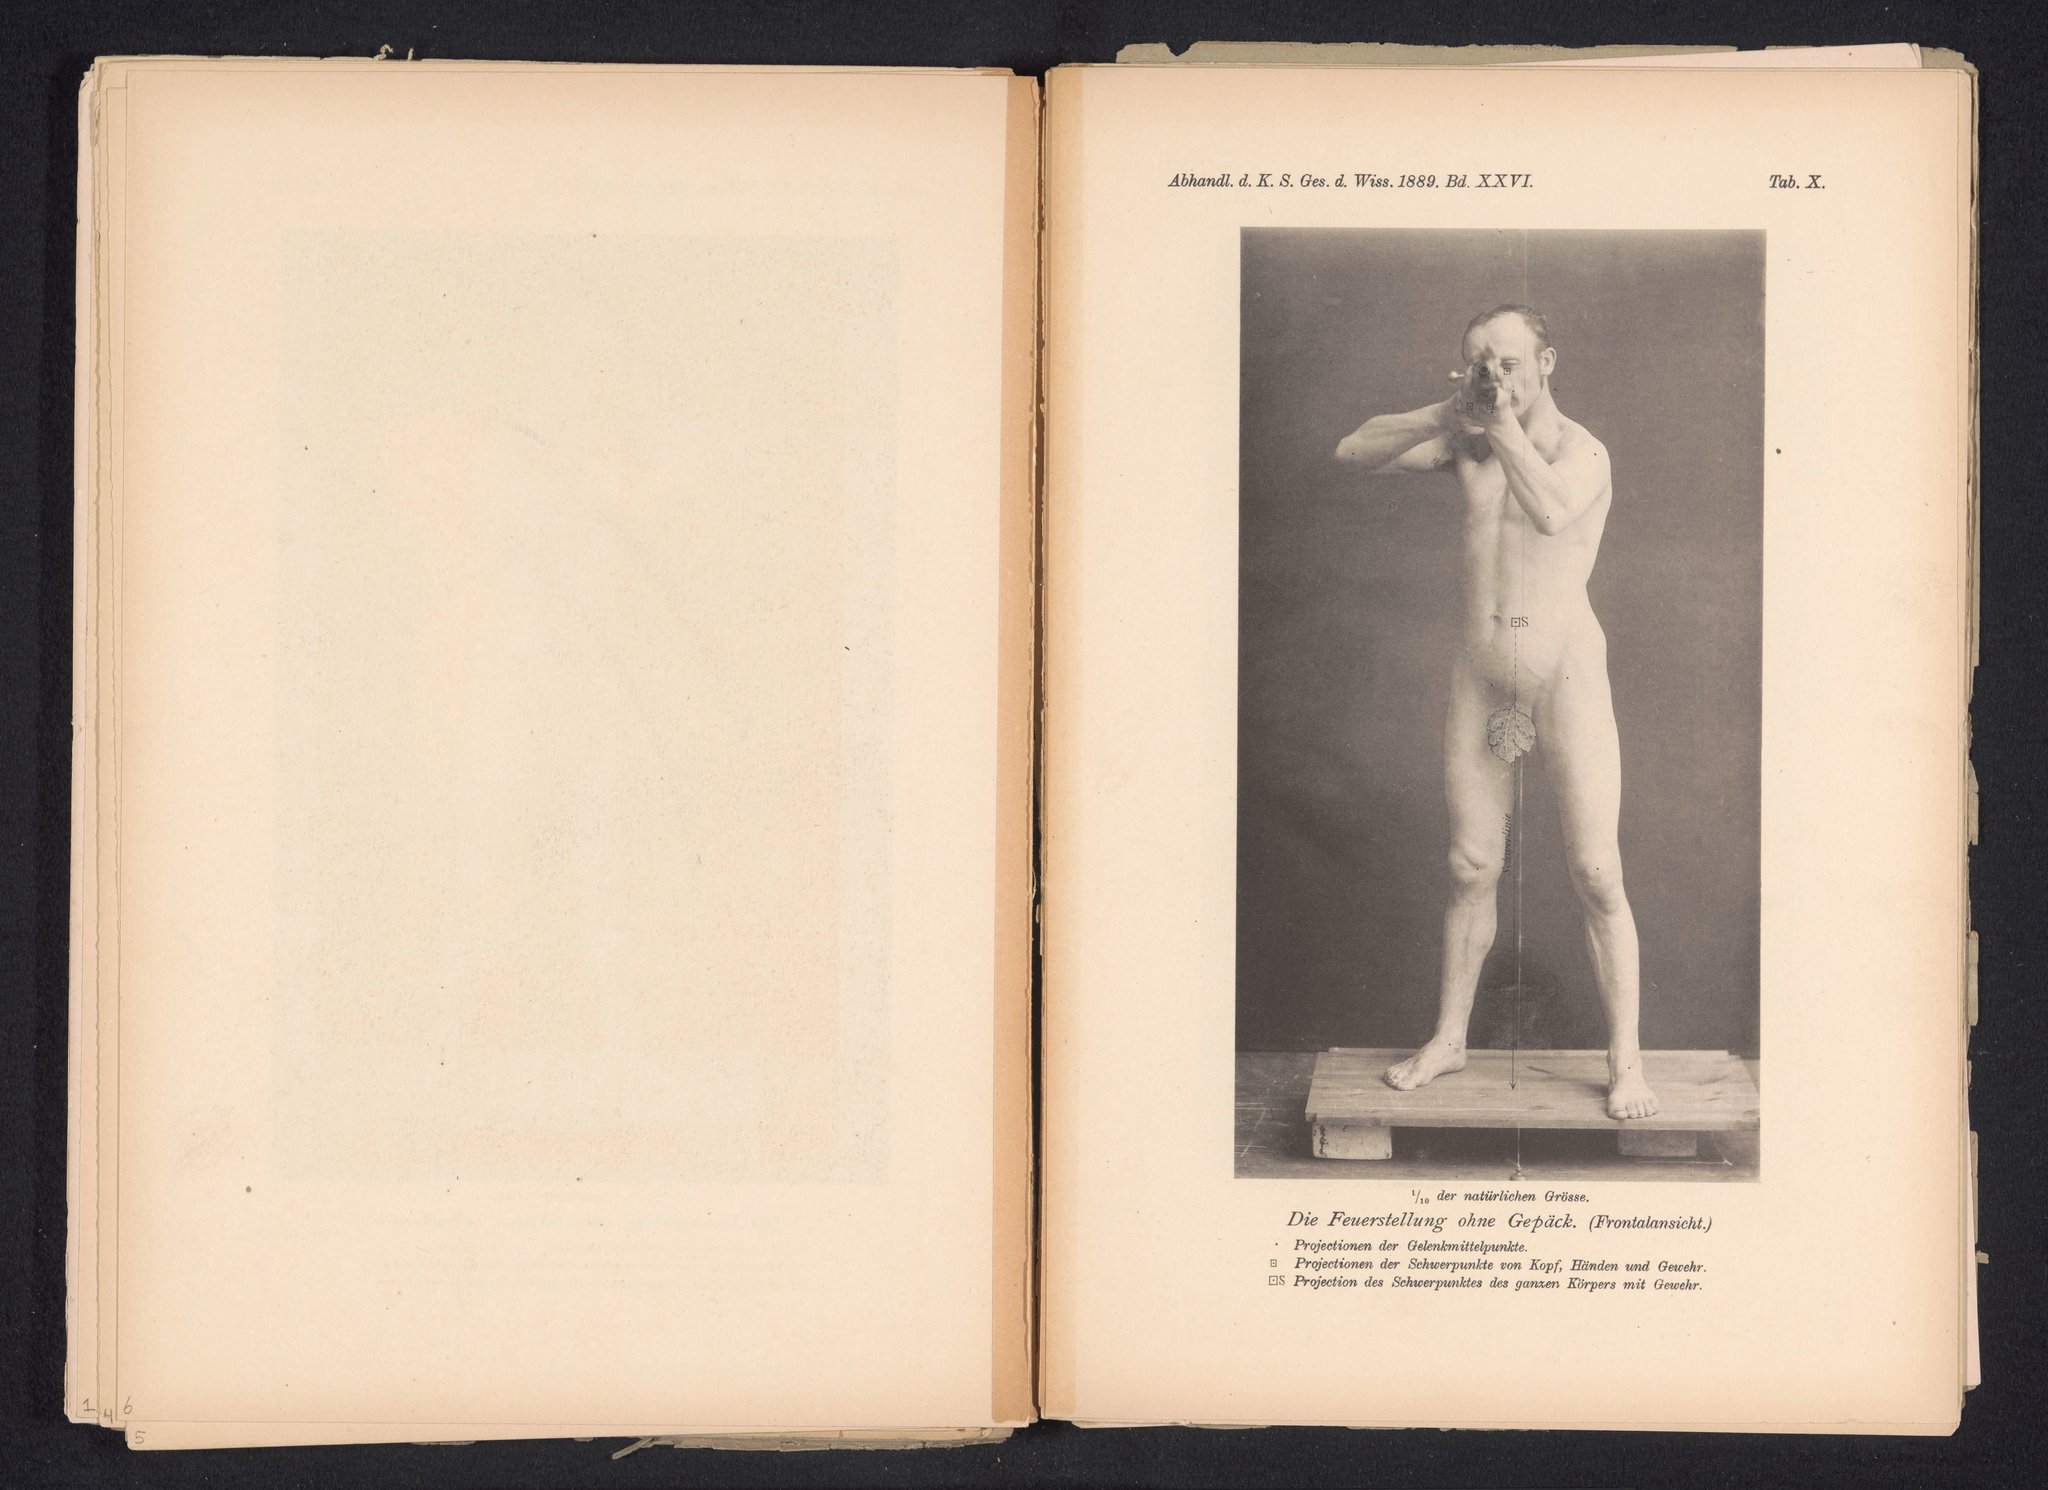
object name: page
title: Die Feuerstellung ohne Gepäck (Frontalansicht)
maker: Anonymous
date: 1880-1890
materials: paper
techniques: photograph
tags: anatomy (non-medical), firearms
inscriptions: number: ‘Tab. X.’, inscription: ‘Schwerlinie. 1/10 der natürlichen Grösse. Projectionen der Gelenkmittelpunkte. Projectionen der Schwerpunkte von Kopf, Händen und Gewehr. Projection des Schwerpunkte des ganzen Körpers mit Gewehr.’